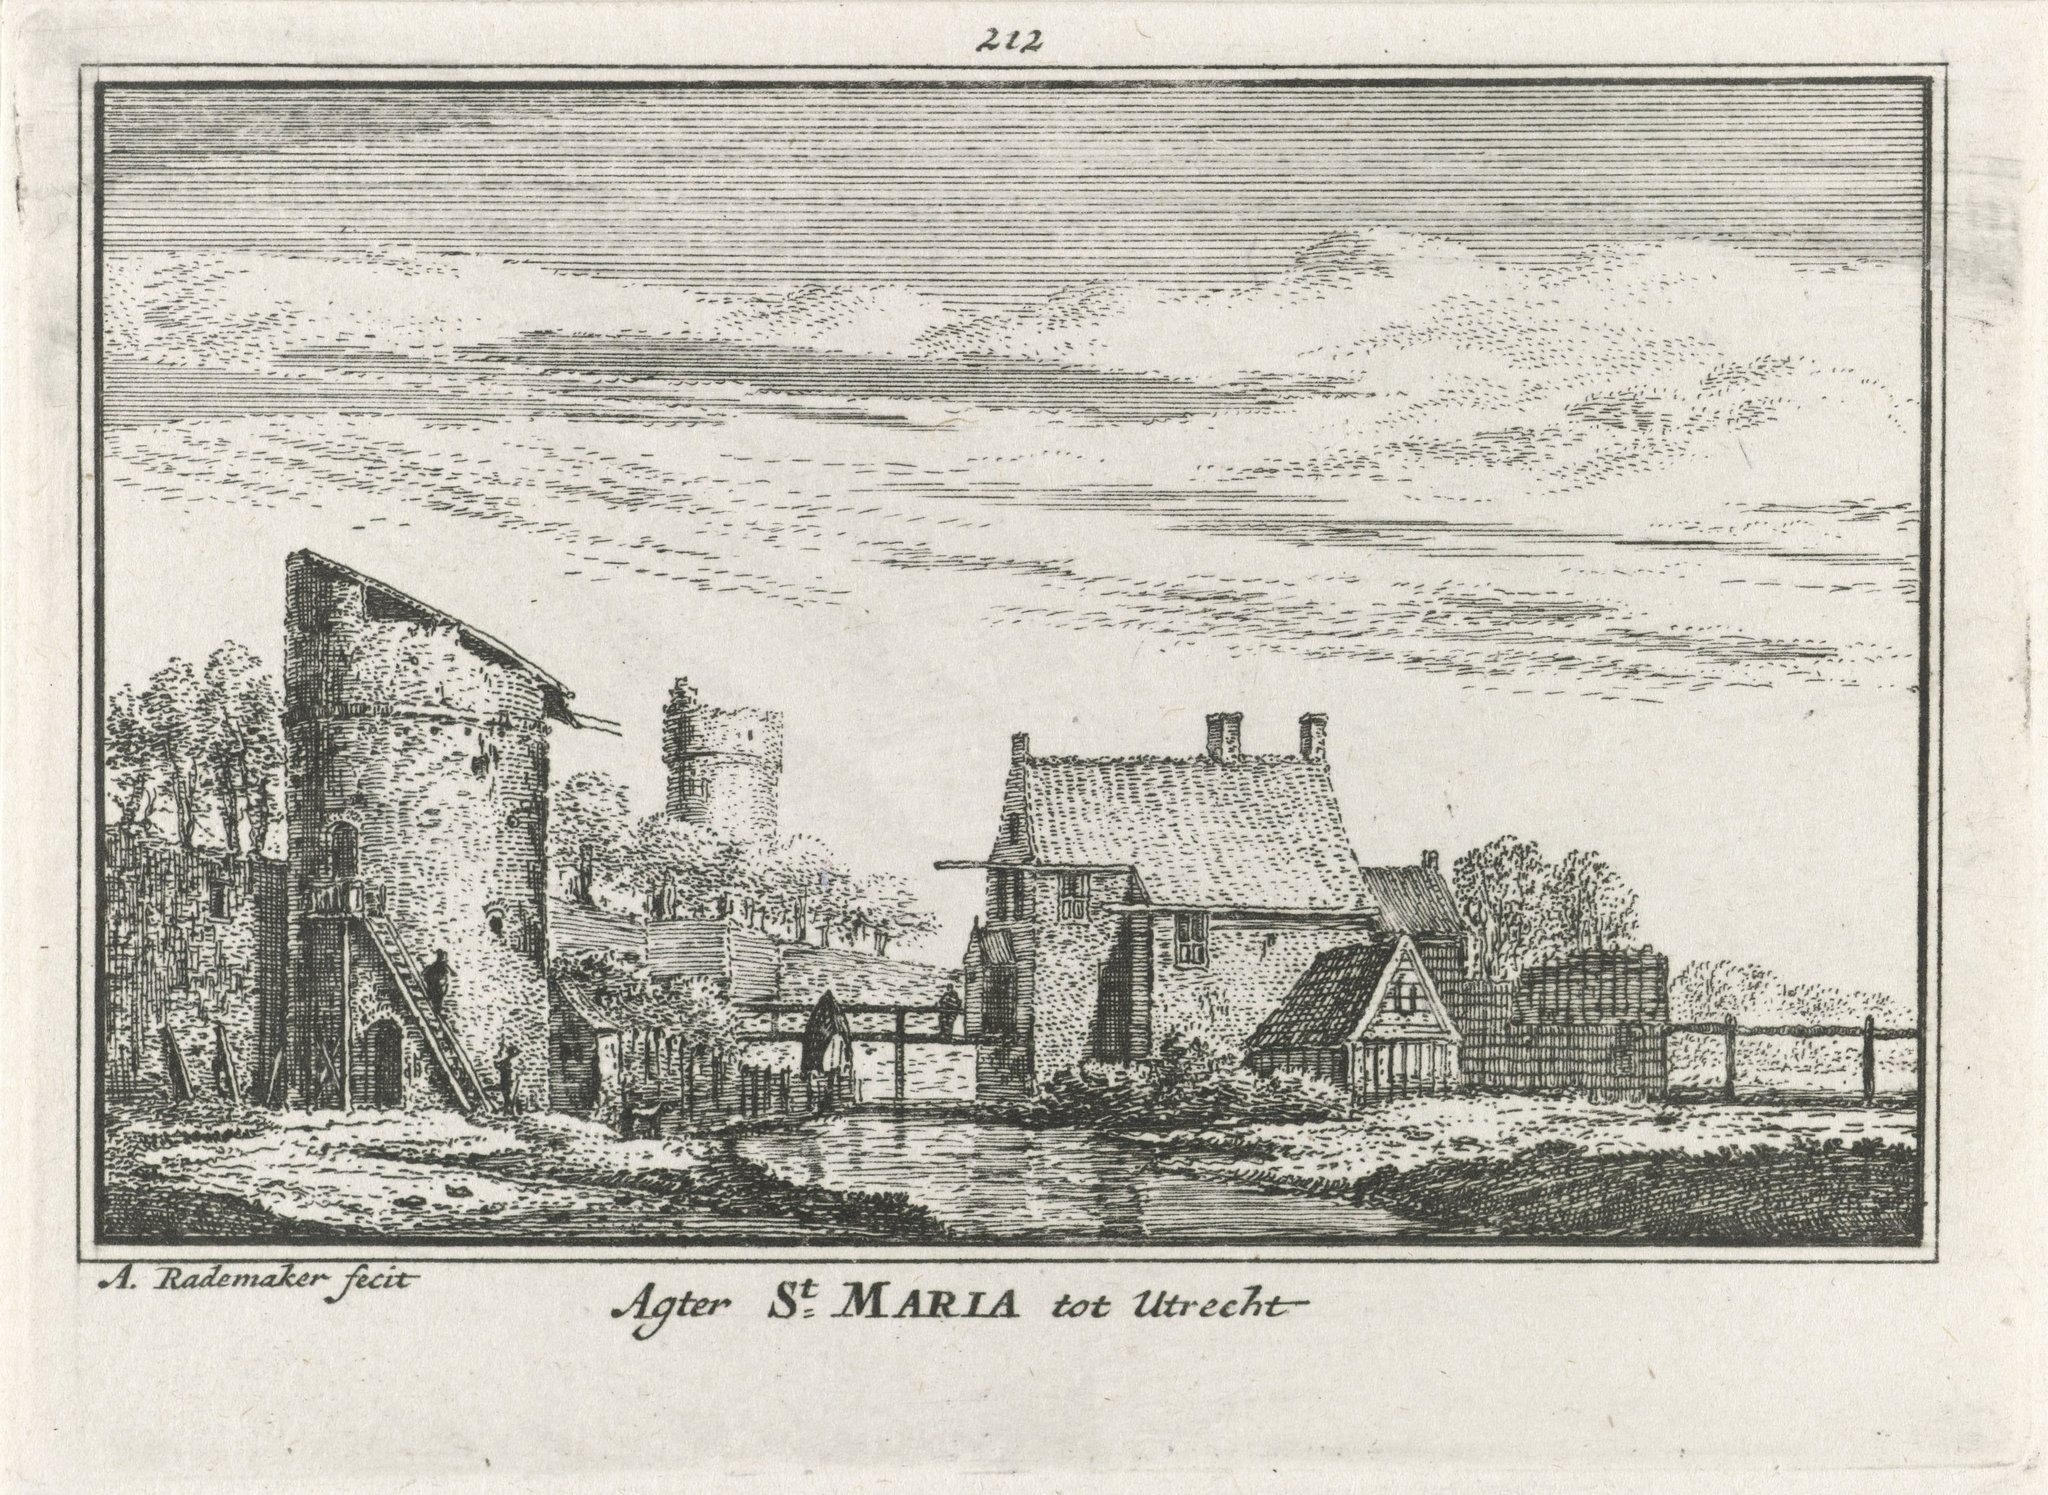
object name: book illustration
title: Agter St. Maria tot Utrecht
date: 1727-1733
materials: paper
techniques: engraving, etching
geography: amsterdam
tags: urban housing, tower (of house or building)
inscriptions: collector's mark: Lugt 2228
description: Illustratie uit: Abraham Rademaker, Matthaeus Brouërius van Niedek, Isaac Le Long, Kabinet van Nederlandsche en Kleefsche outheden en (...) voorname stads- en landgebouwen, Willem Barents en Antoni Schoonenburg: Amsterdam, 1727-1733, ill. nr. 212.